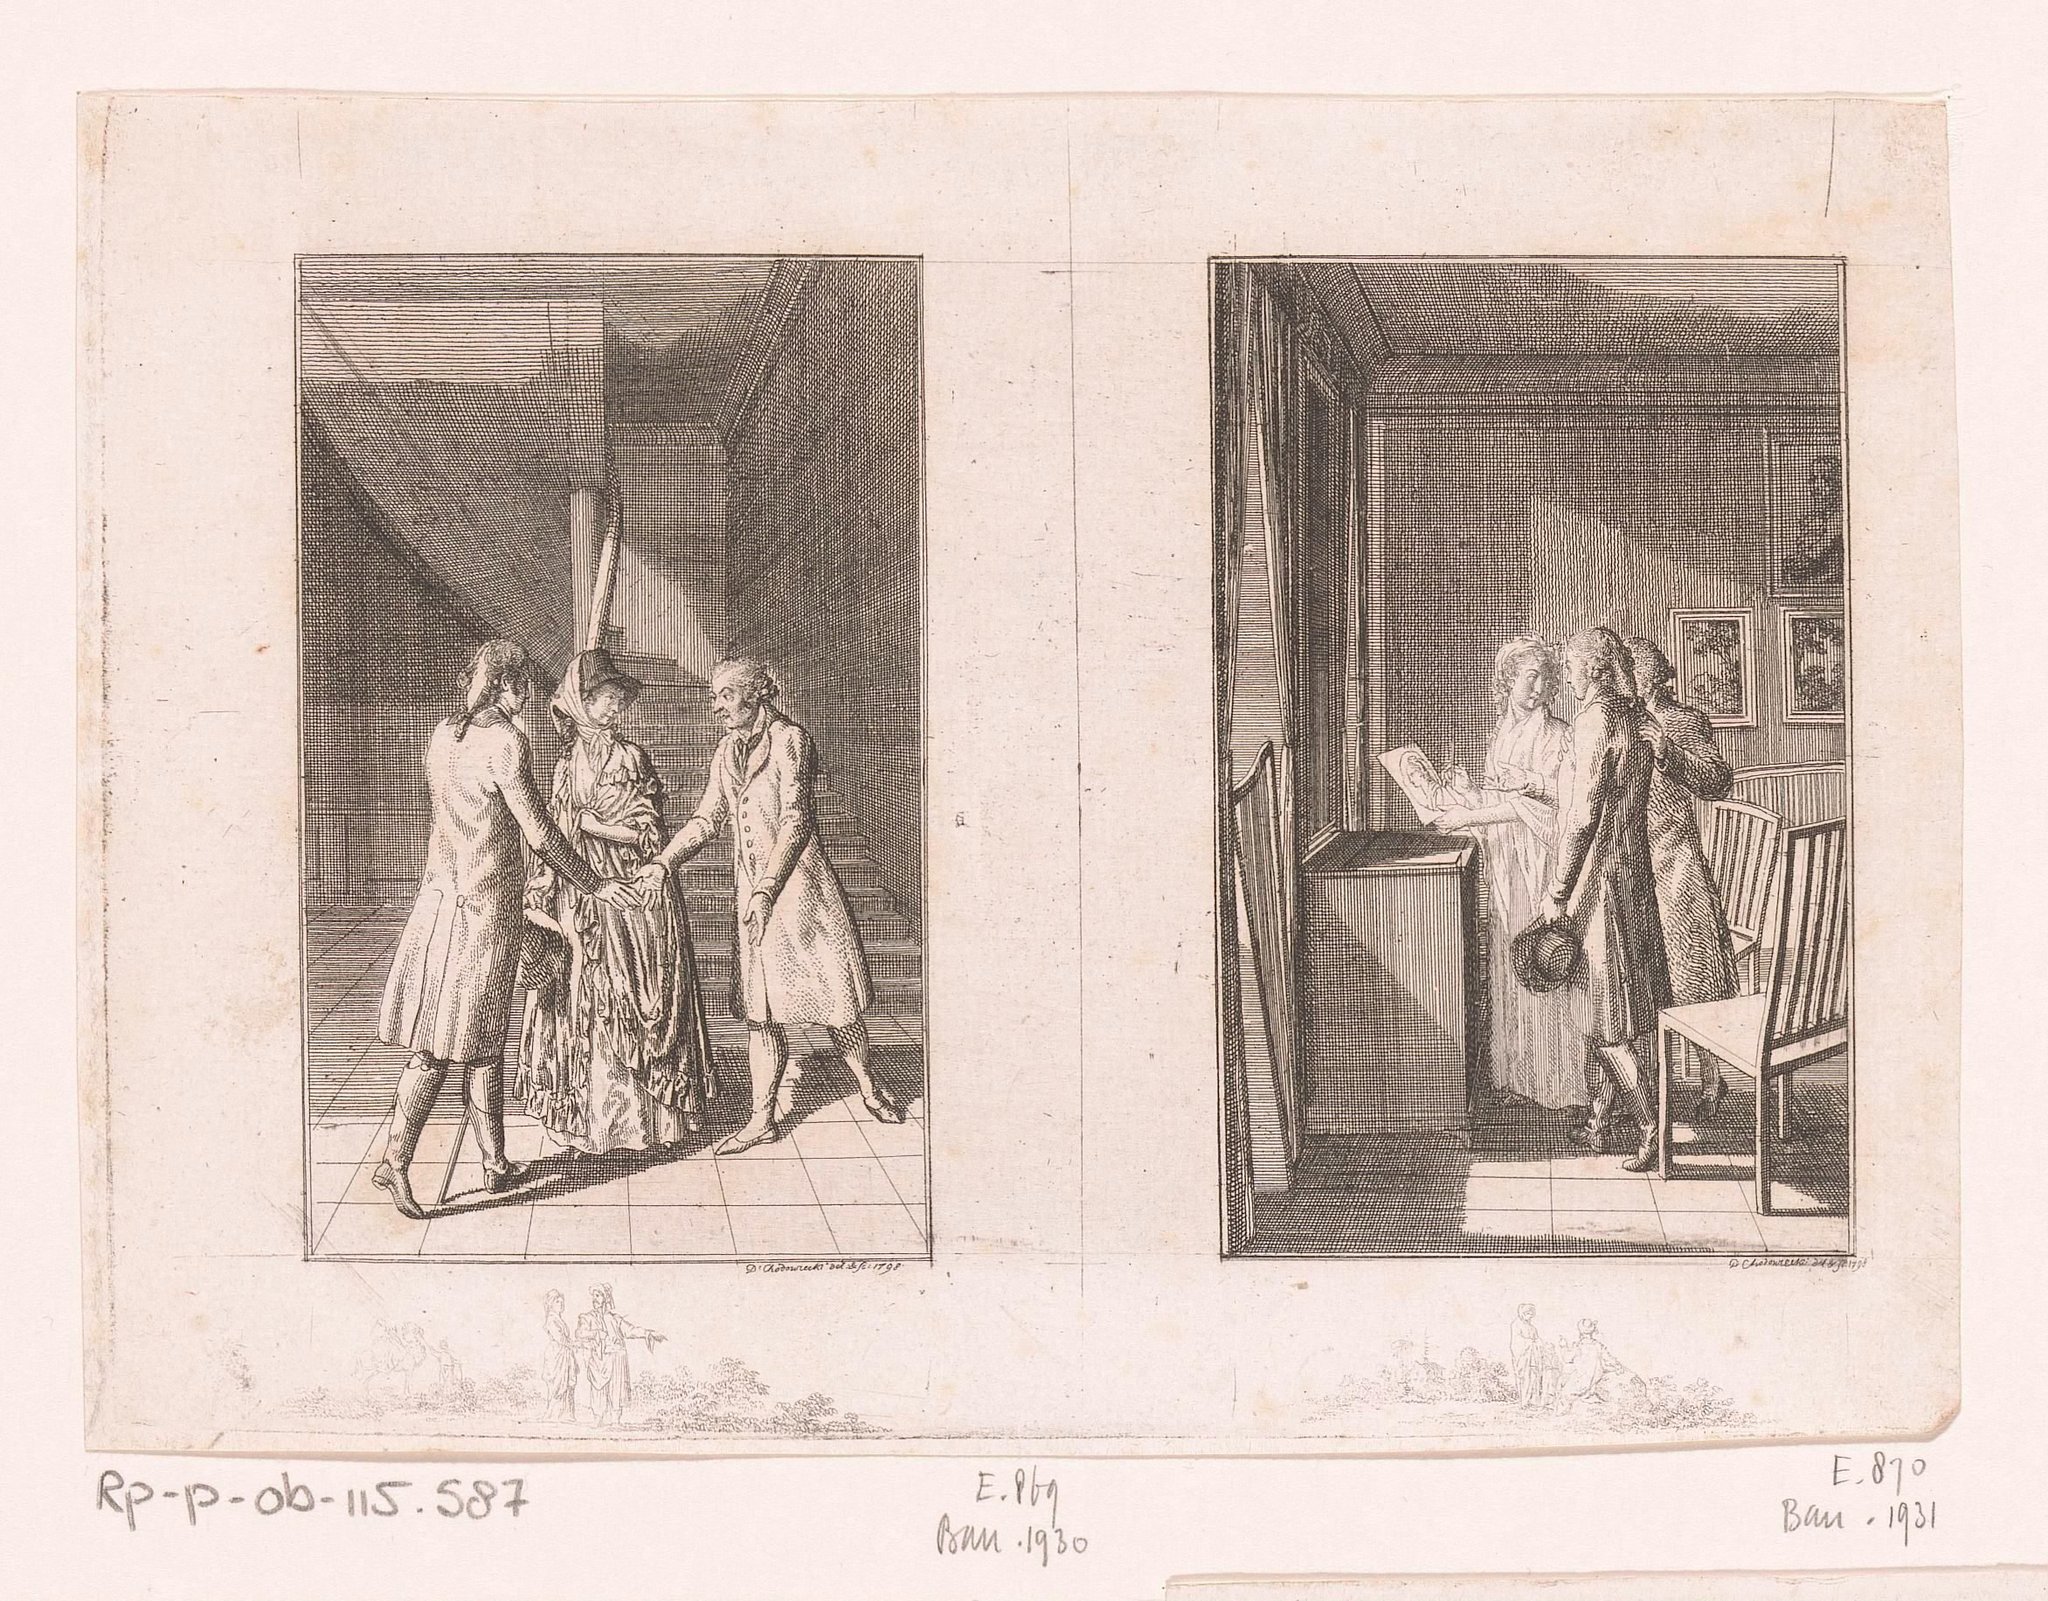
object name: print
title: Twee voorstellingen uit de verhalen van Wilhelm Gottlieb Becker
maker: daniel nikolaus chodowiecki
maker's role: draughtsman, print maker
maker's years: 1726-1801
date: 1798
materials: paper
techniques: etching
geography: berlin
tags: shaking hands, 'dextrarum junctio', staircase, portrait, self-portrait of artist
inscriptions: collector's mark: Lugt 2228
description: Latere staat gebruikt voor: Becker, Wilhelm Gottlieb. Almanach und Taschenbuch zum geselligen Vergnügen von W. G. Becker für 1799. Leipzig: Voss und Comp., 1798.